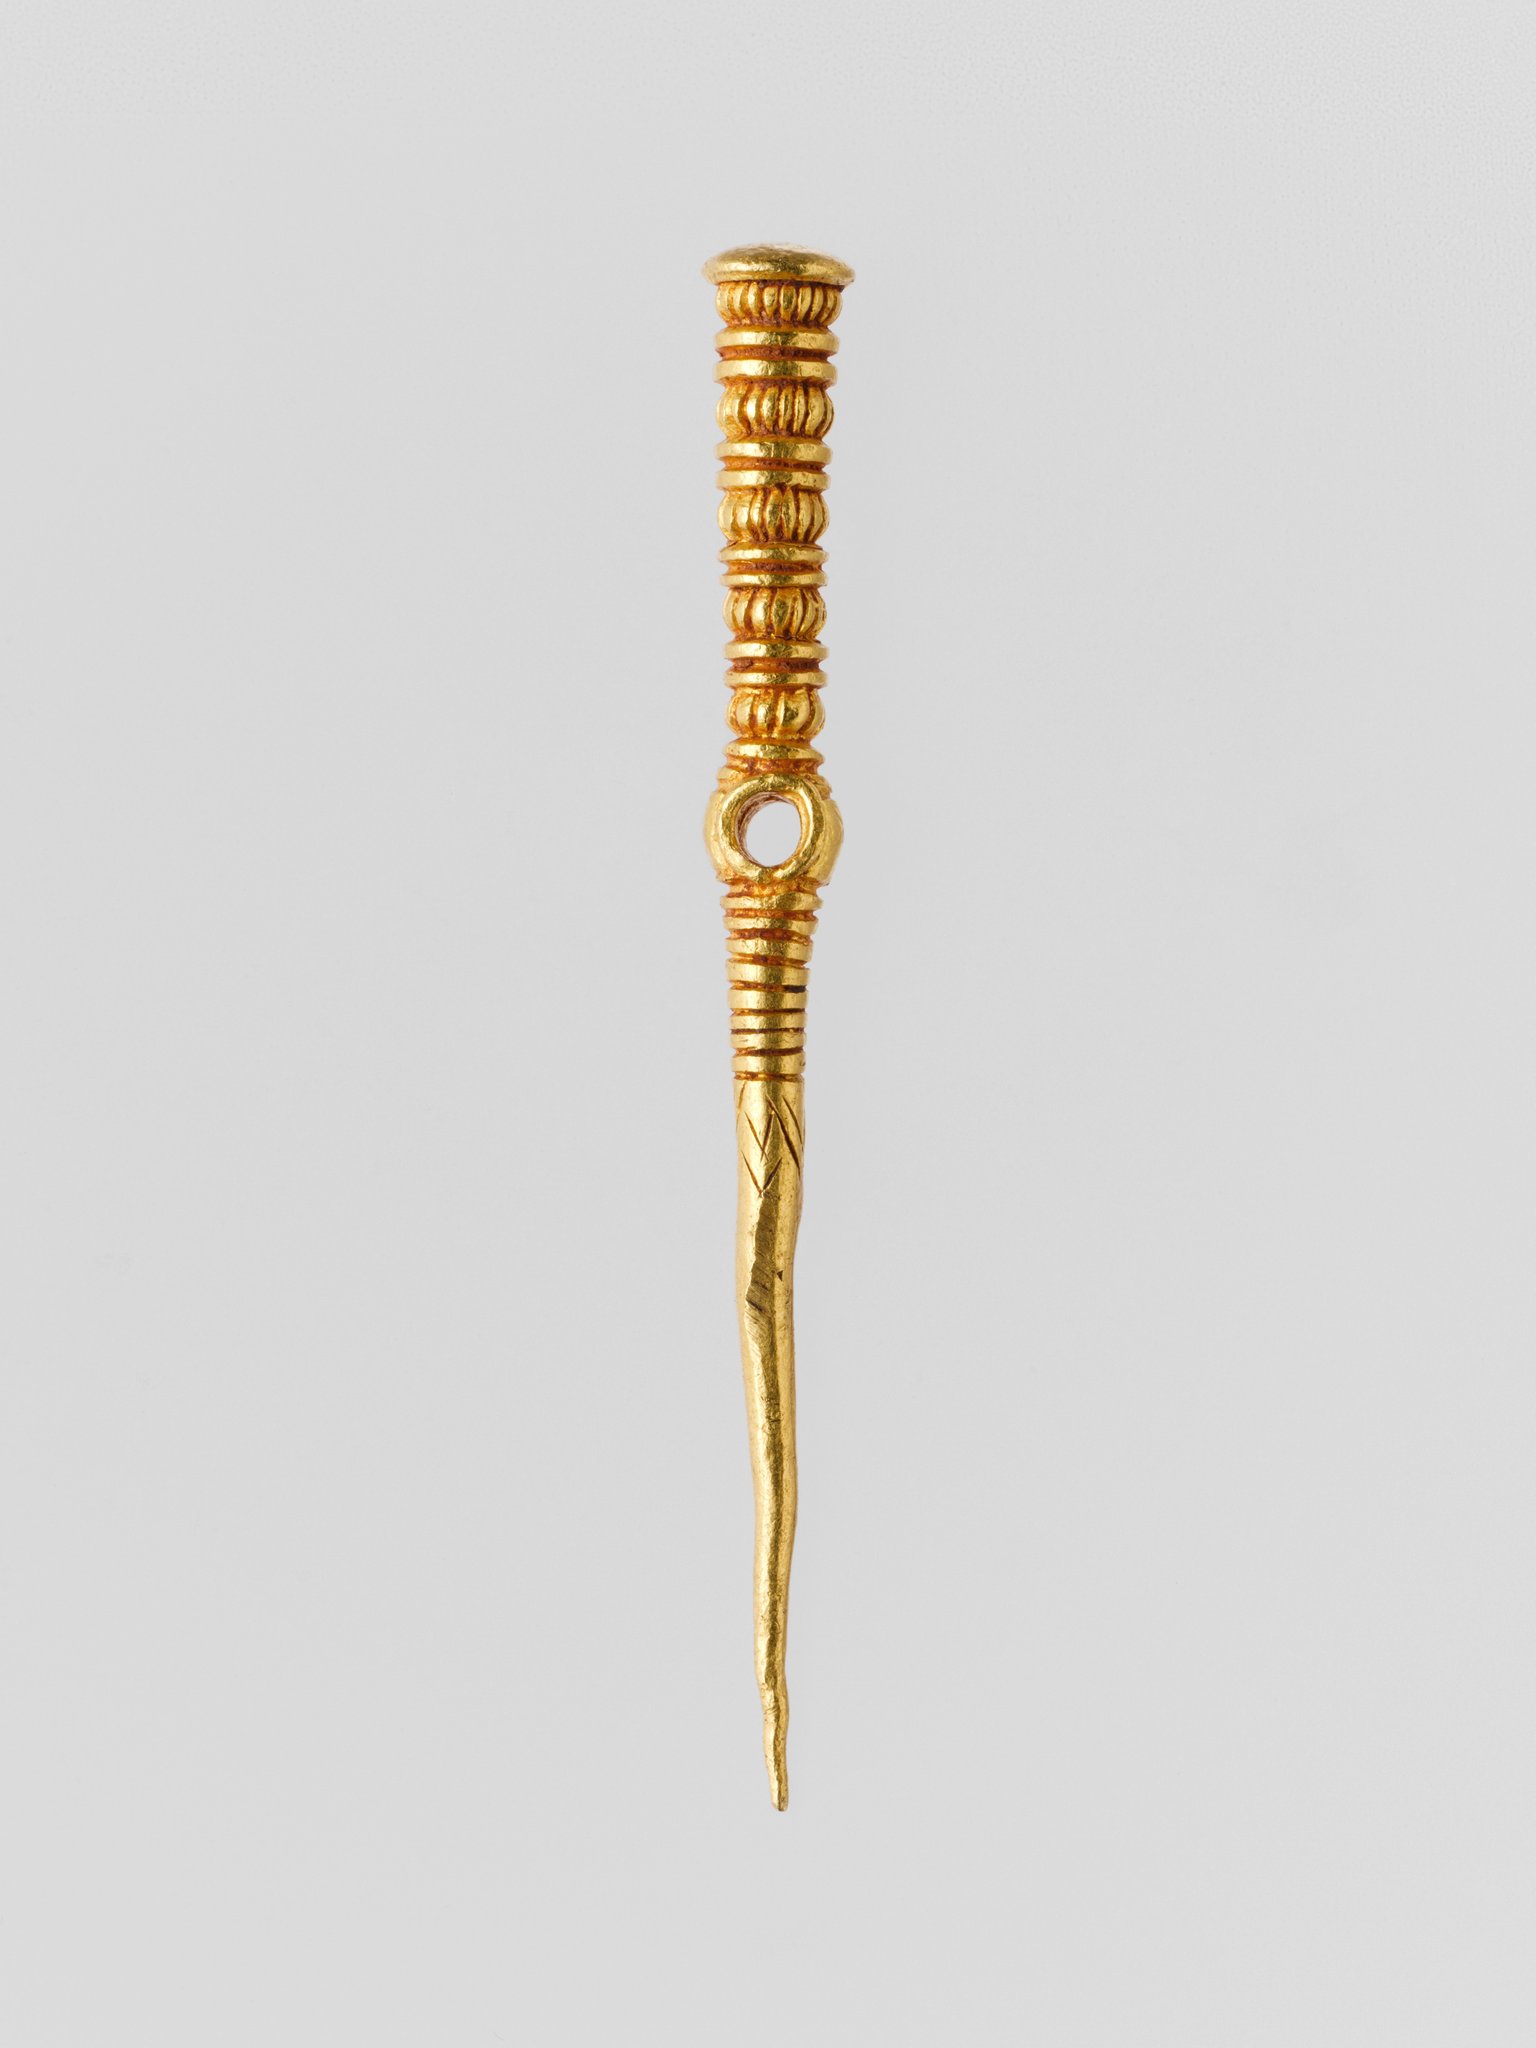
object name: pin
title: Gold pin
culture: mycenaean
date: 1400-1300 BCE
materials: gold